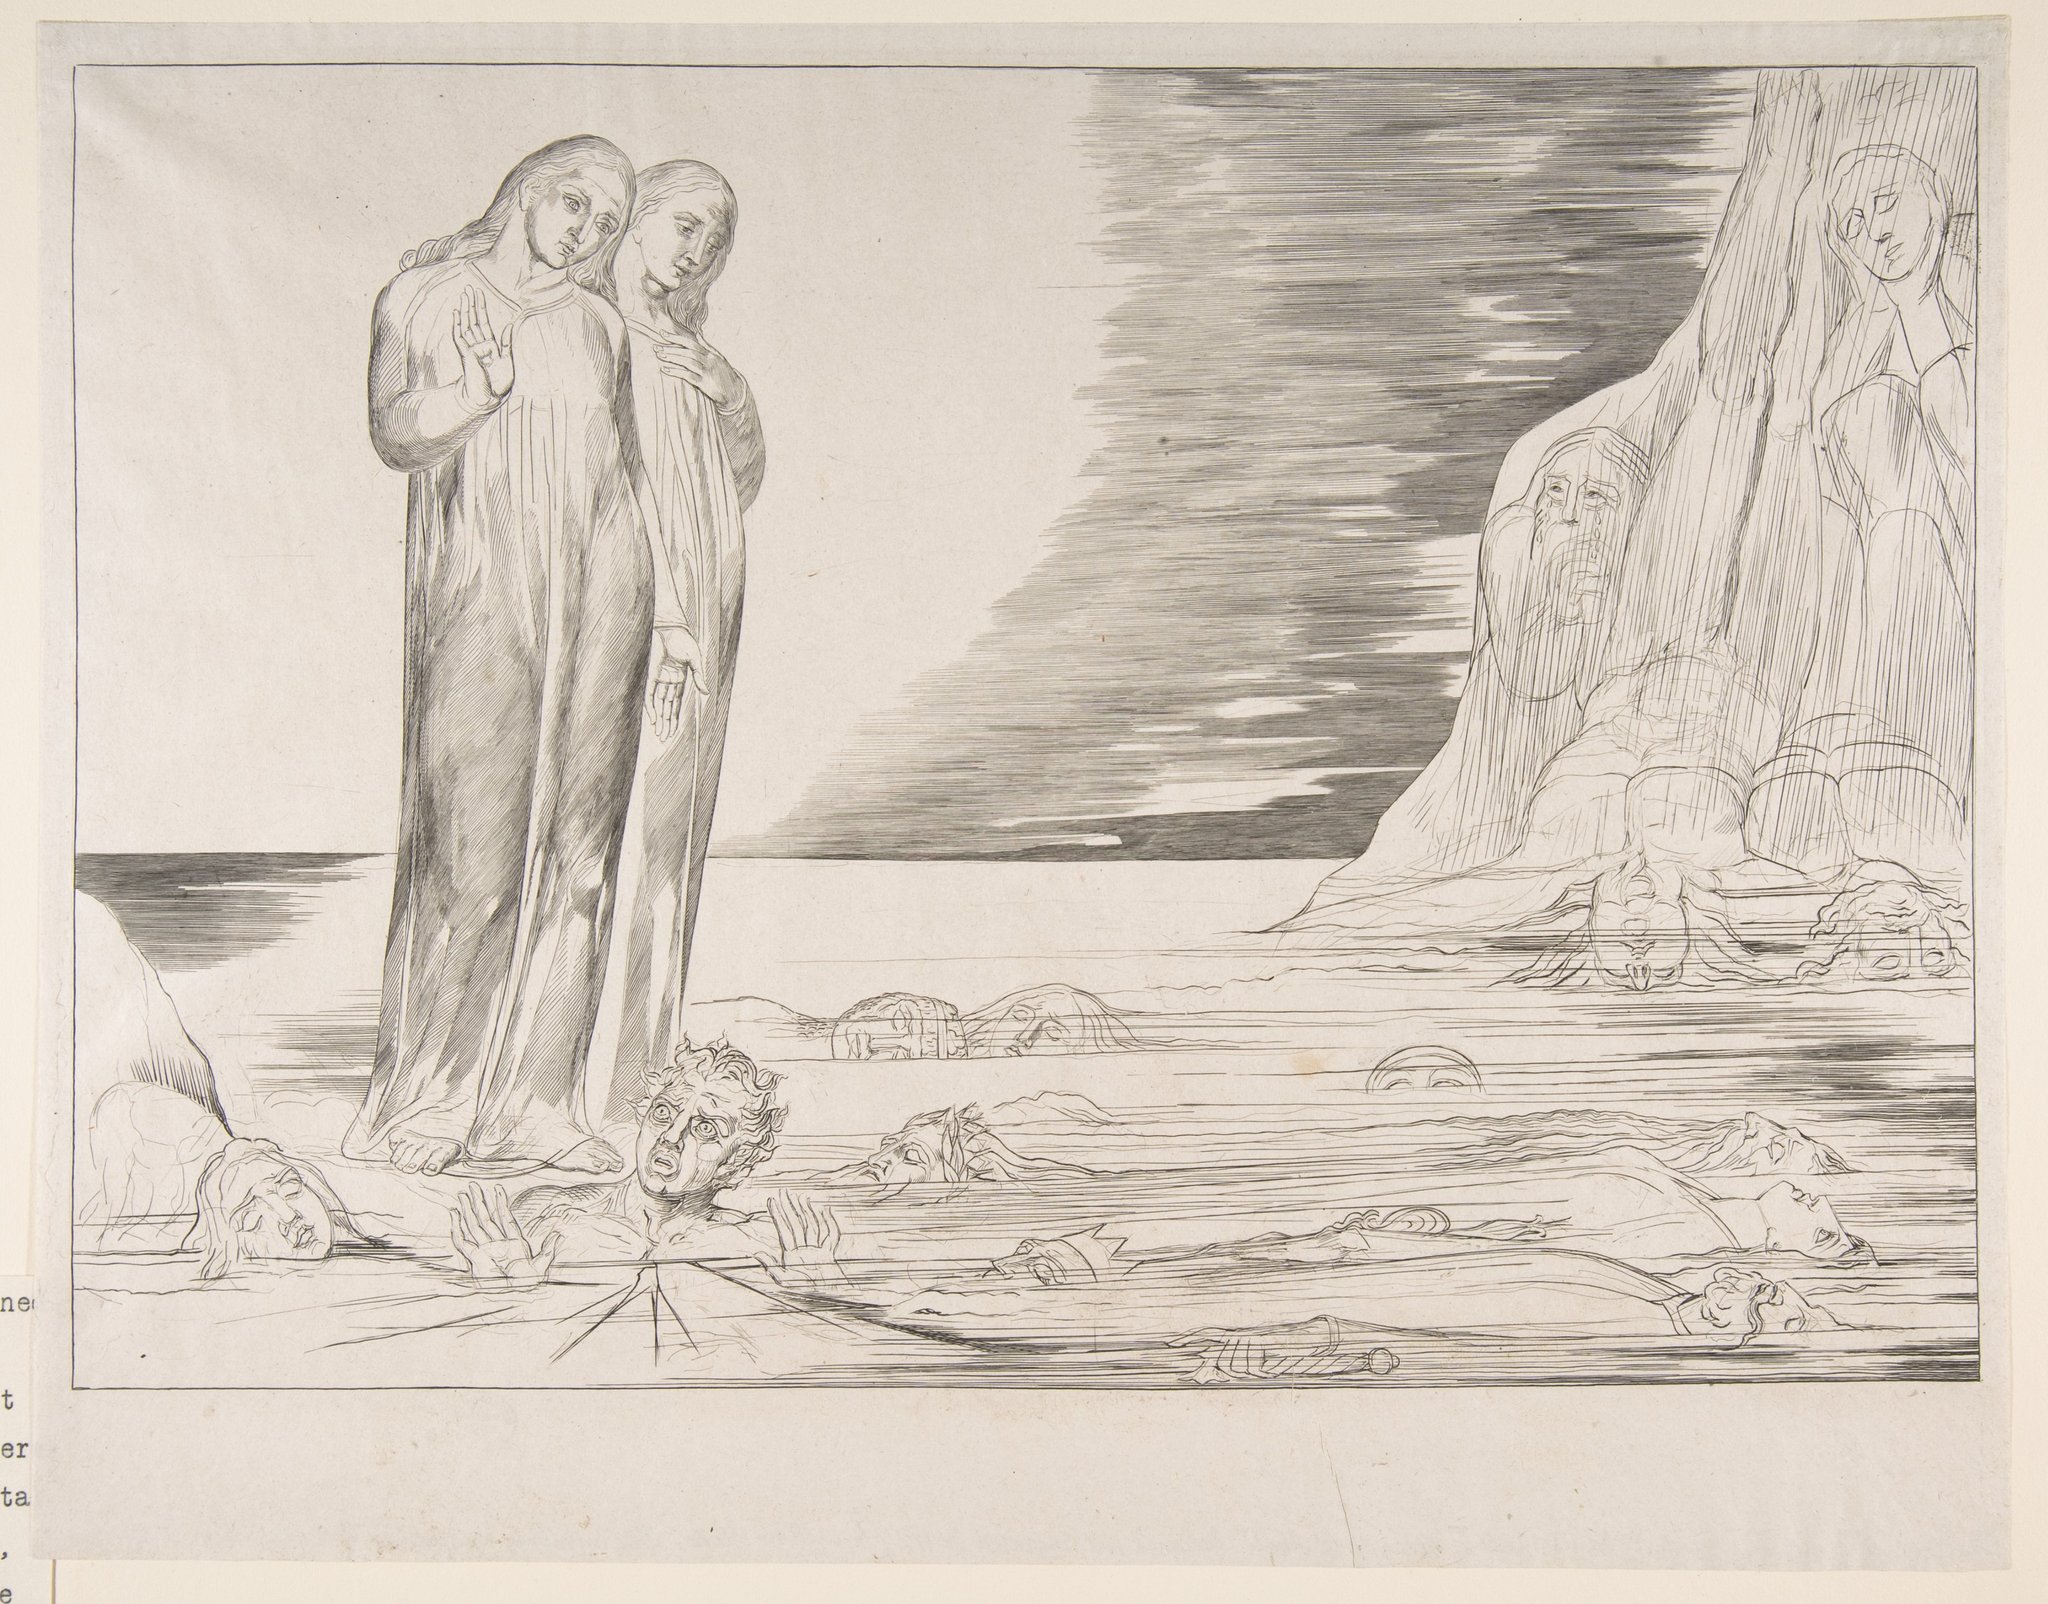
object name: print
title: The Circle of Traitors: Dante's Foot Striking Bocca degli Abbate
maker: william blake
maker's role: artist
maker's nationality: british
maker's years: 1757-1827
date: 1825-1827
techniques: engraving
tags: heads,women